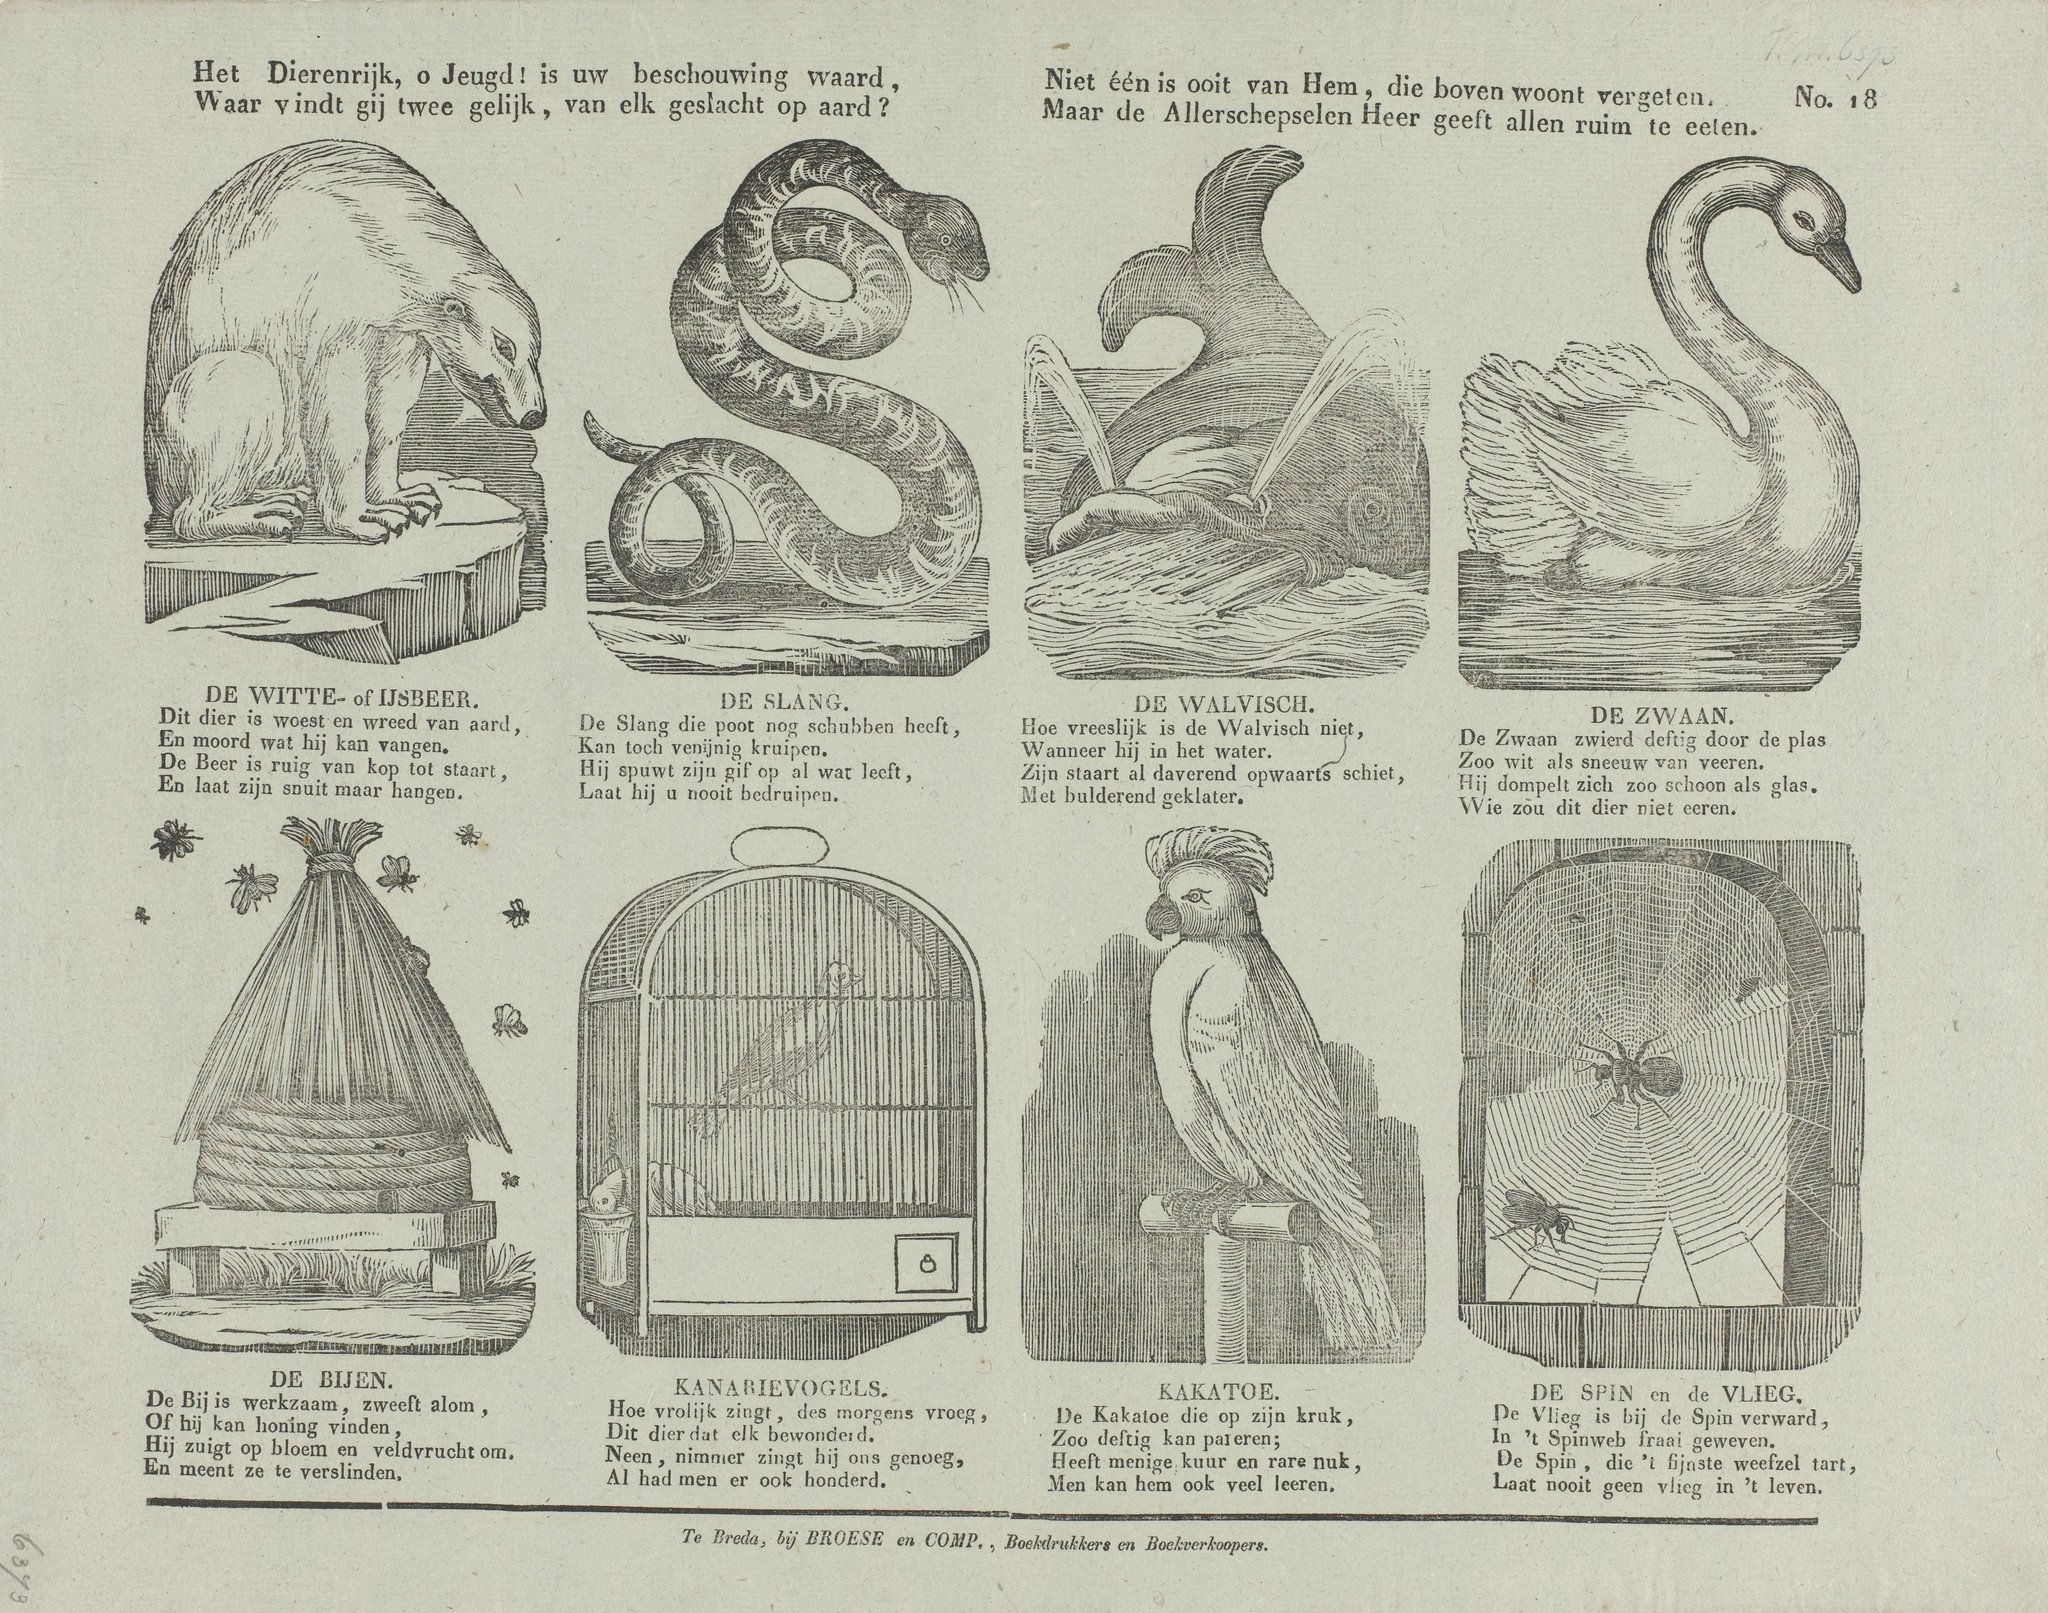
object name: popular print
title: Het dierenrijk, o jeugd! is uw beschouwing waard, / Waar vindt gij twee gelijk, van elk geslacht op aard? / Niet één is ooit van Hem, die boven woont vergeten. / Maar de allerschepselen Heer geeft allen ruim te eeten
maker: Anonymous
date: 1828-1853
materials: paper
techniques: letterpress printing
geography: breda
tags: beasts of prey, predatory animals: polar bear, snakes, ornamental birds: cockatoo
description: Blad met 8 voorstellingen van dieren, waaronder een ijsbeer, een slang en een kaketoe. Onder elke voorstelling titel en een vierregelig vers. Genummerd rechtsboven: No. 18.